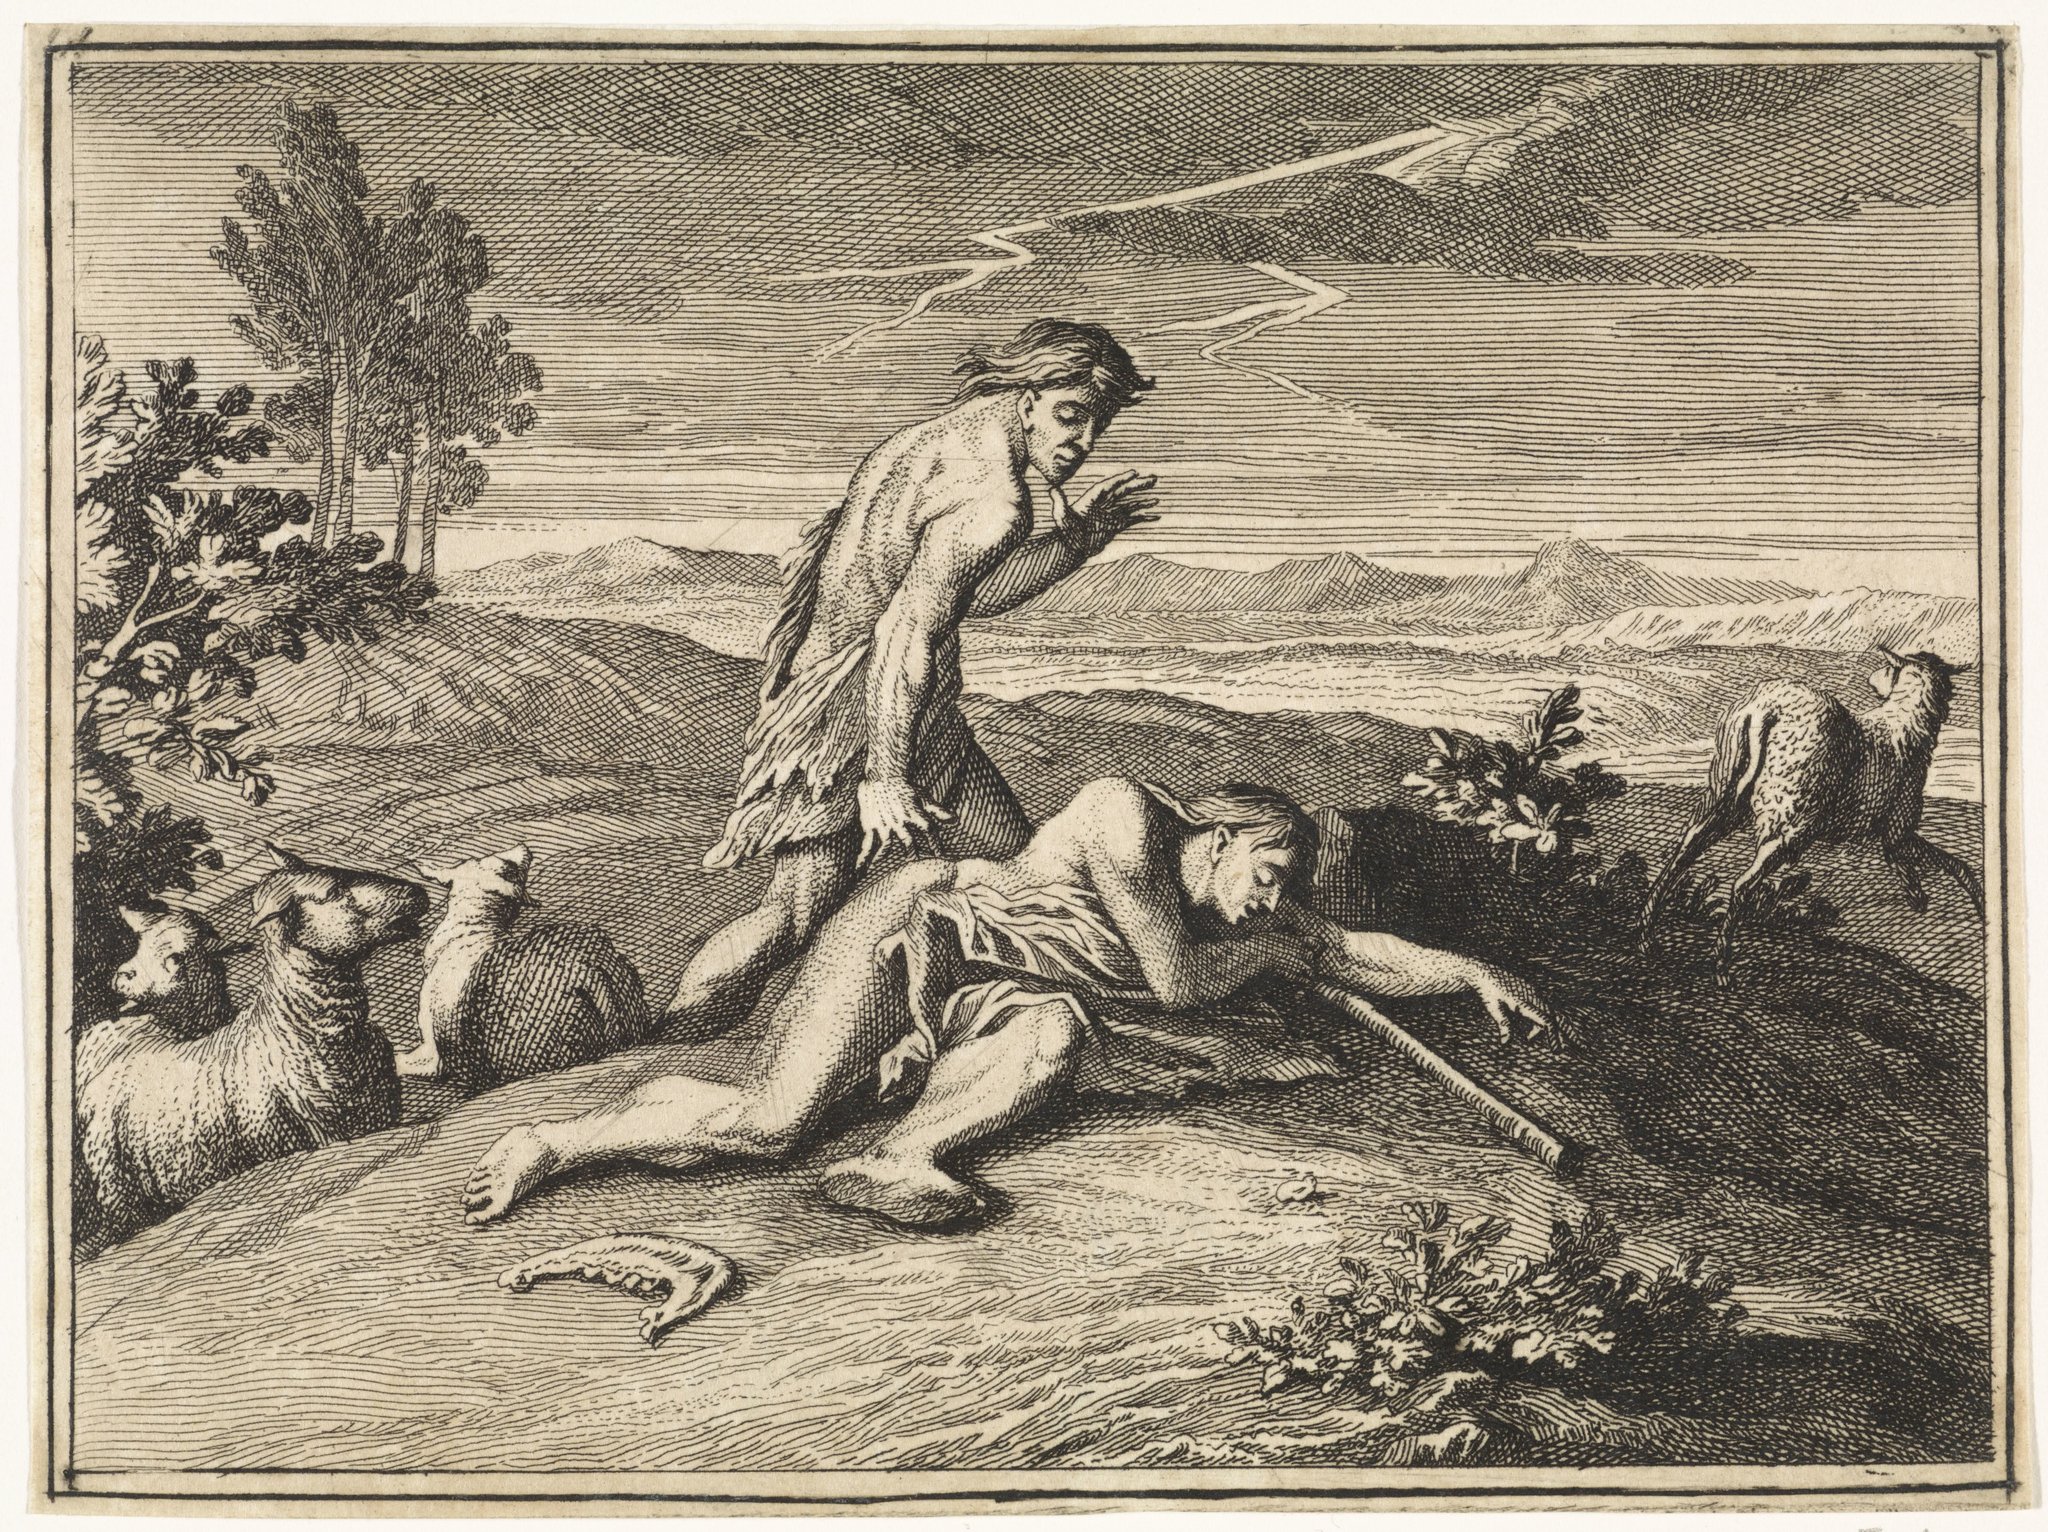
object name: print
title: Kaïn vlucht na de moord op Abel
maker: caspar luyken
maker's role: draughtsman, print maker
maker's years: 1672-1708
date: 1712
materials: paper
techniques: etching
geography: amsterdam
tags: the flight of cain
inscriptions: collector's mark: Lugt 2228, number: ‘9’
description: Illustratie uit: Luyken, Jan. De schriftuurlyke geschiedenissen en gelykenissen van het Oude en Nieuwe Verbond, 2 delen. Amsterdam: Wed. Pieter Arentsz II en Cornelis van der Sys, 1712, dl. I.